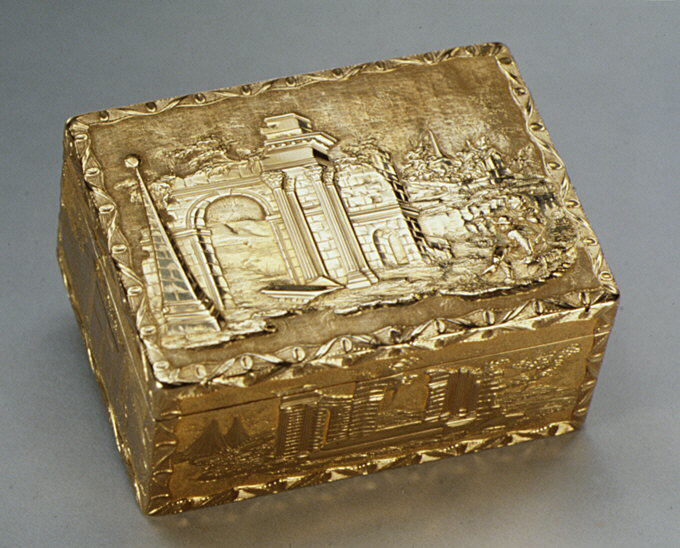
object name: snuffbox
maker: jean moynat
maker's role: maker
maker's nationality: french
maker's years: 1661-1761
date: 1753-1754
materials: gold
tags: ruins